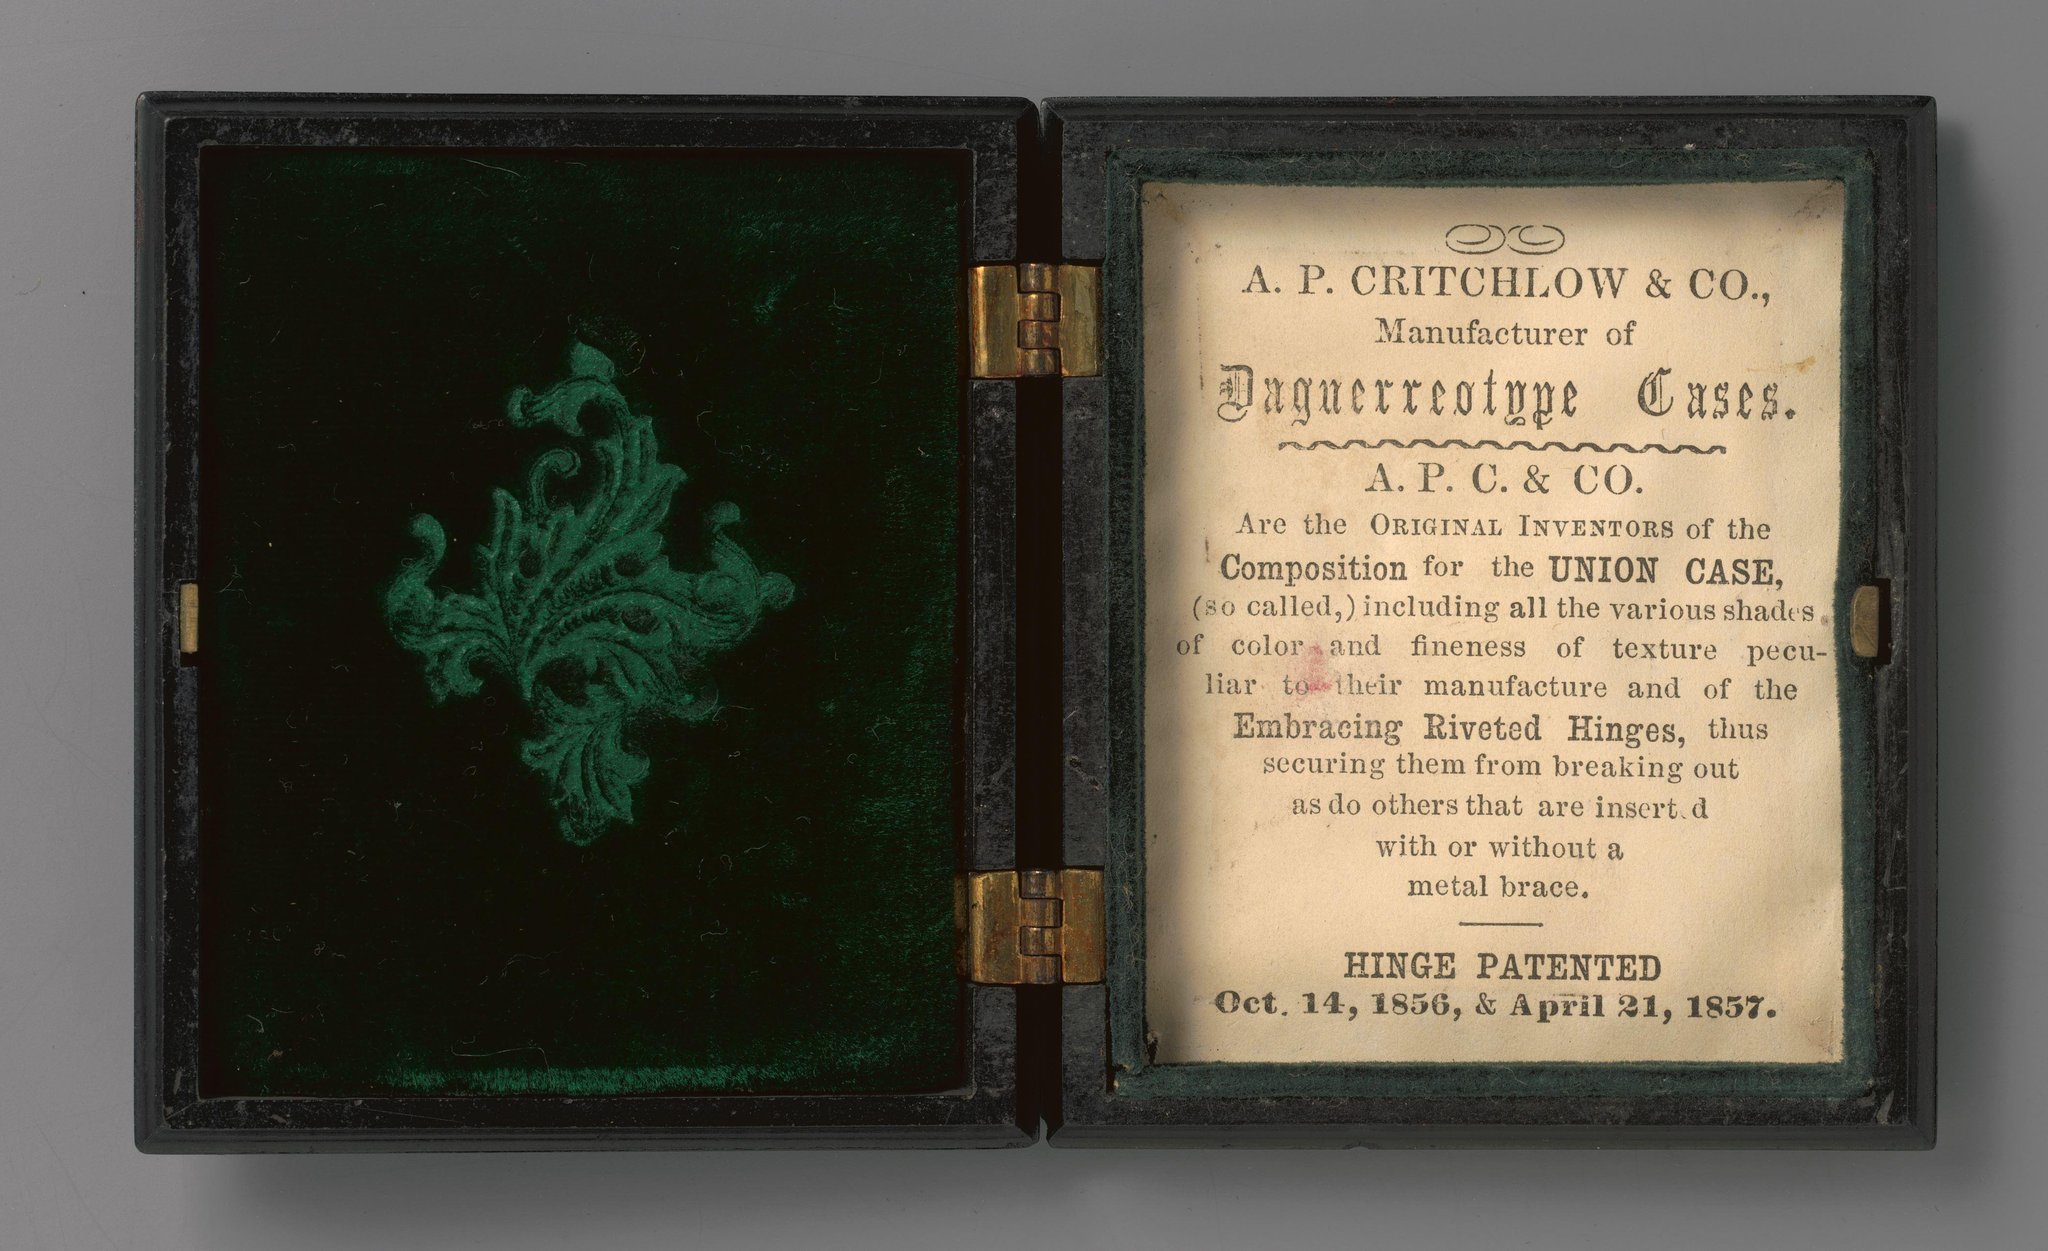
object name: union case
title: Lege union case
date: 1857-1858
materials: metal, paper, plastic, velvet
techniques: letterpress printing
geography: united states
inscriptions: inscription: ‘A.P. Critchlow & Co.,/ Manufacturer of/ Daguerreotype Cases./ A.P.C. & Co./ Are the original inventors of the/ Composition for the UNION CASE,/ (so called,) including all the various shades/ of color and fineness of texture pecu-/ liar to their manufacture and of the/ Embracing Riveted Hinges, thus/ securing them from breaking out/ as do other that are inserted/ with or without a/ metal brace./ Hinge patented/ Oct. 14, 1856 & April 21, 1857.’